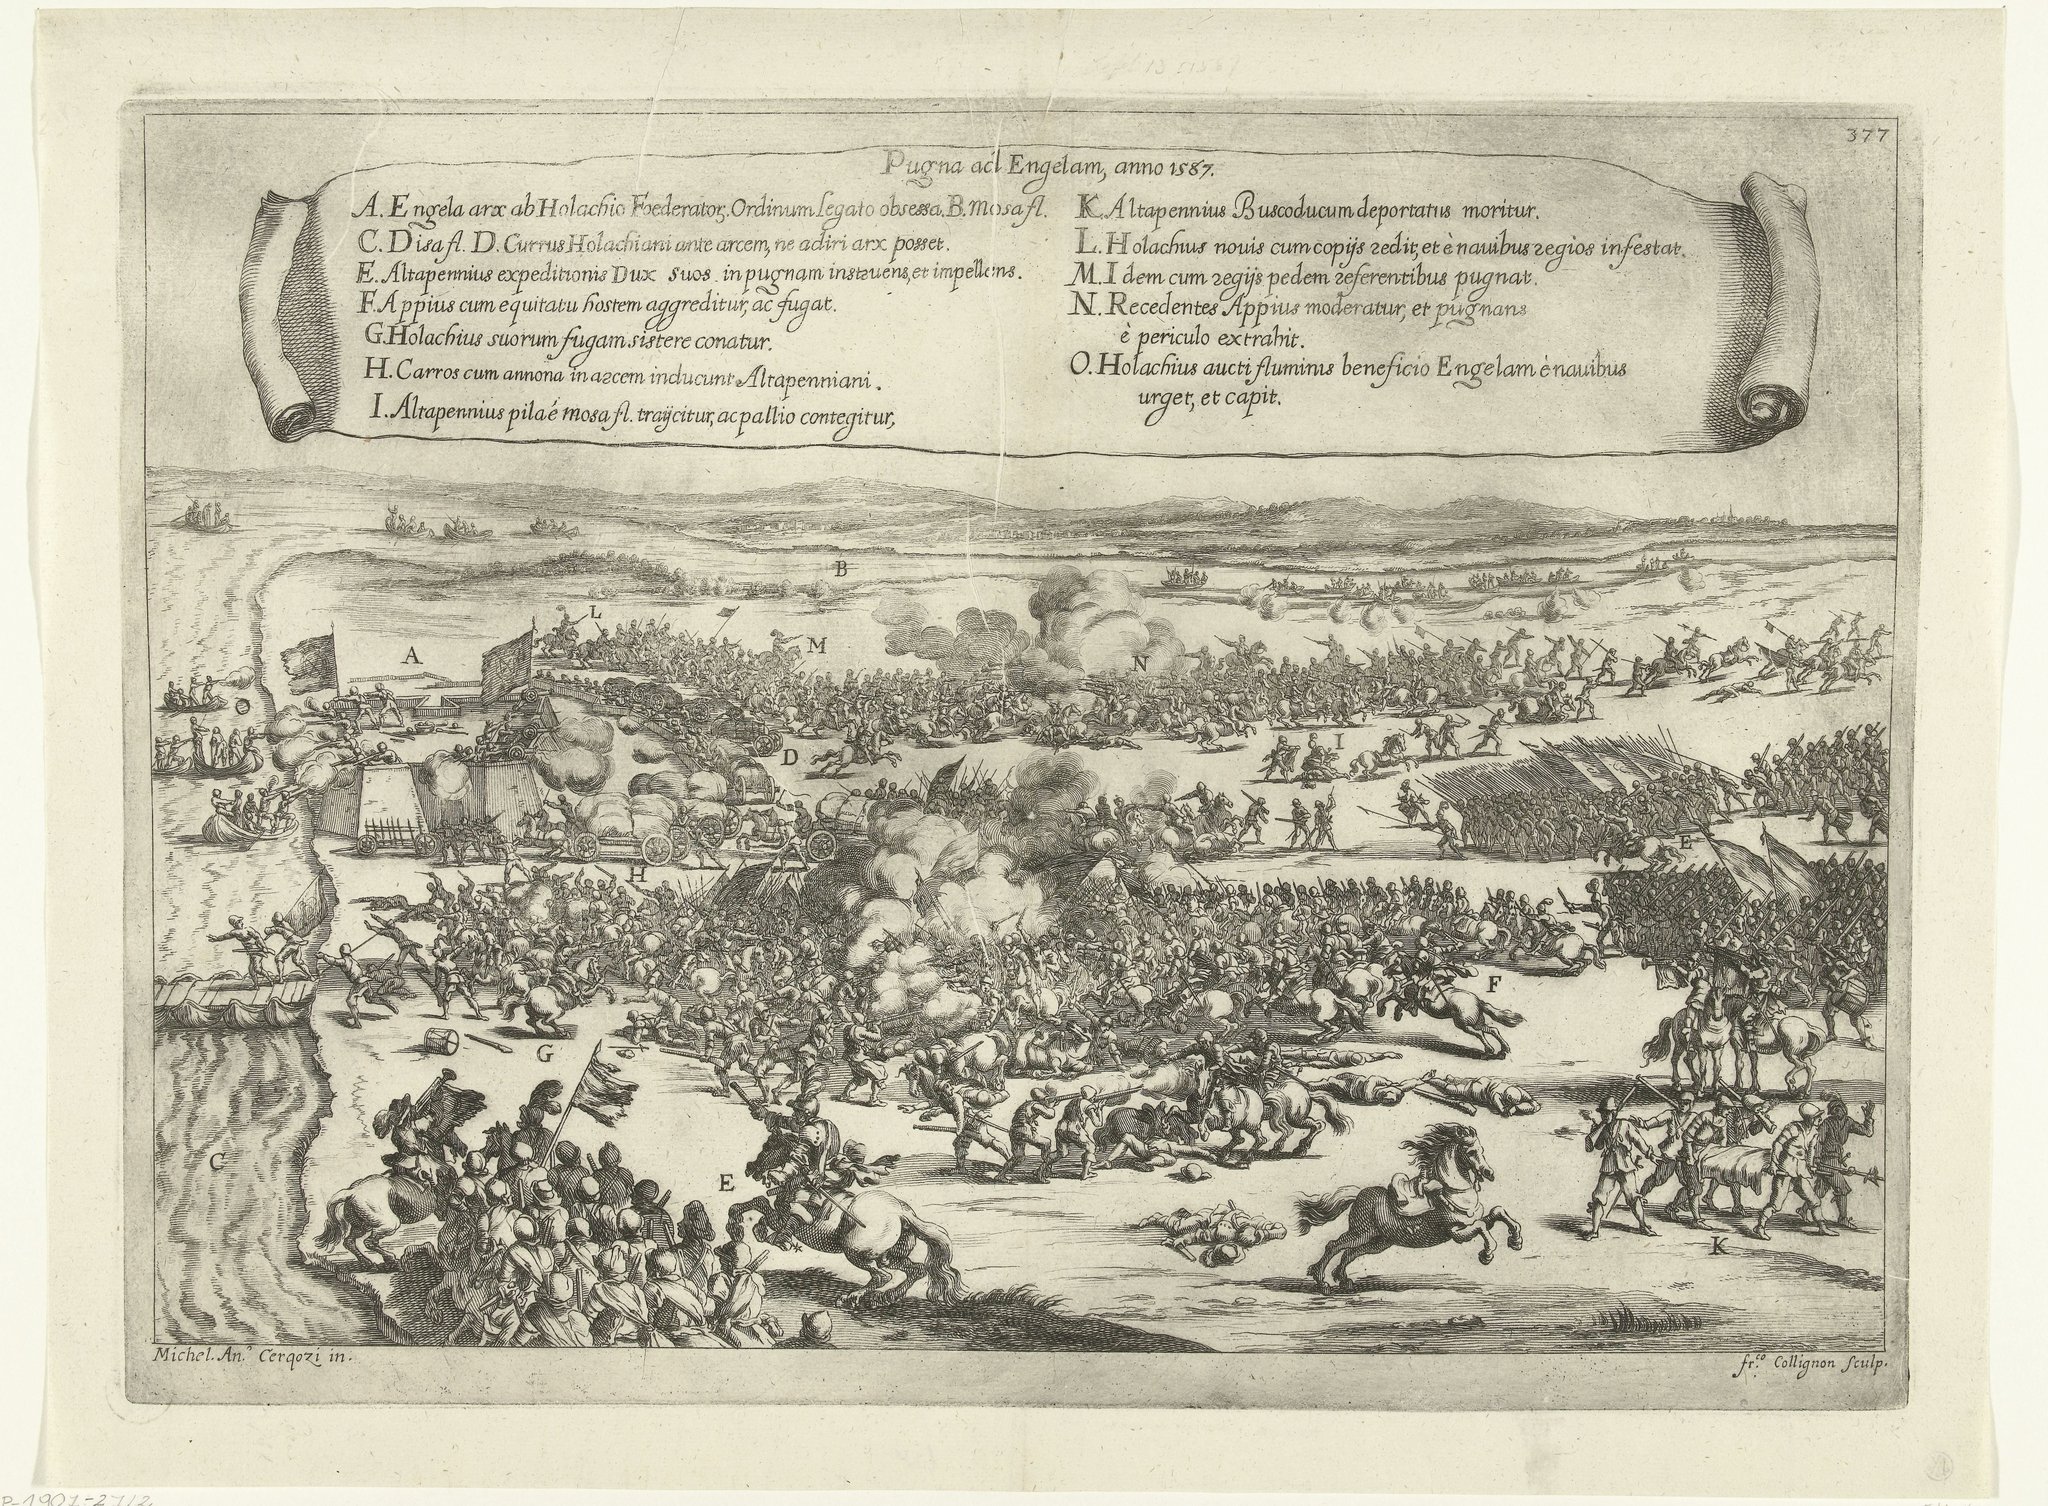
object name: print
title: Veldslag bij Engelen, 1587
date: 1645-1647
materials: paper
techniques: etching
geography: rome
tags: battle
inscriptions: collector's mark: Lugt 148, collector's mark: Lugt 514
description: Slag bij Engelen in de Kempen bij Den Bosch, 13 juli 1587. Troepen van Hohenlohe verdedigen een versterkte schans bij Engelen (later versterkt en omgedoopt tot Crèvecoeur). Bij de slag sneuvelt Haultepenne, rechtsvoor wordt zijn lichaam weggedragen. Bovenin een banderol met de titel en de legenda A-O in het Latijn.